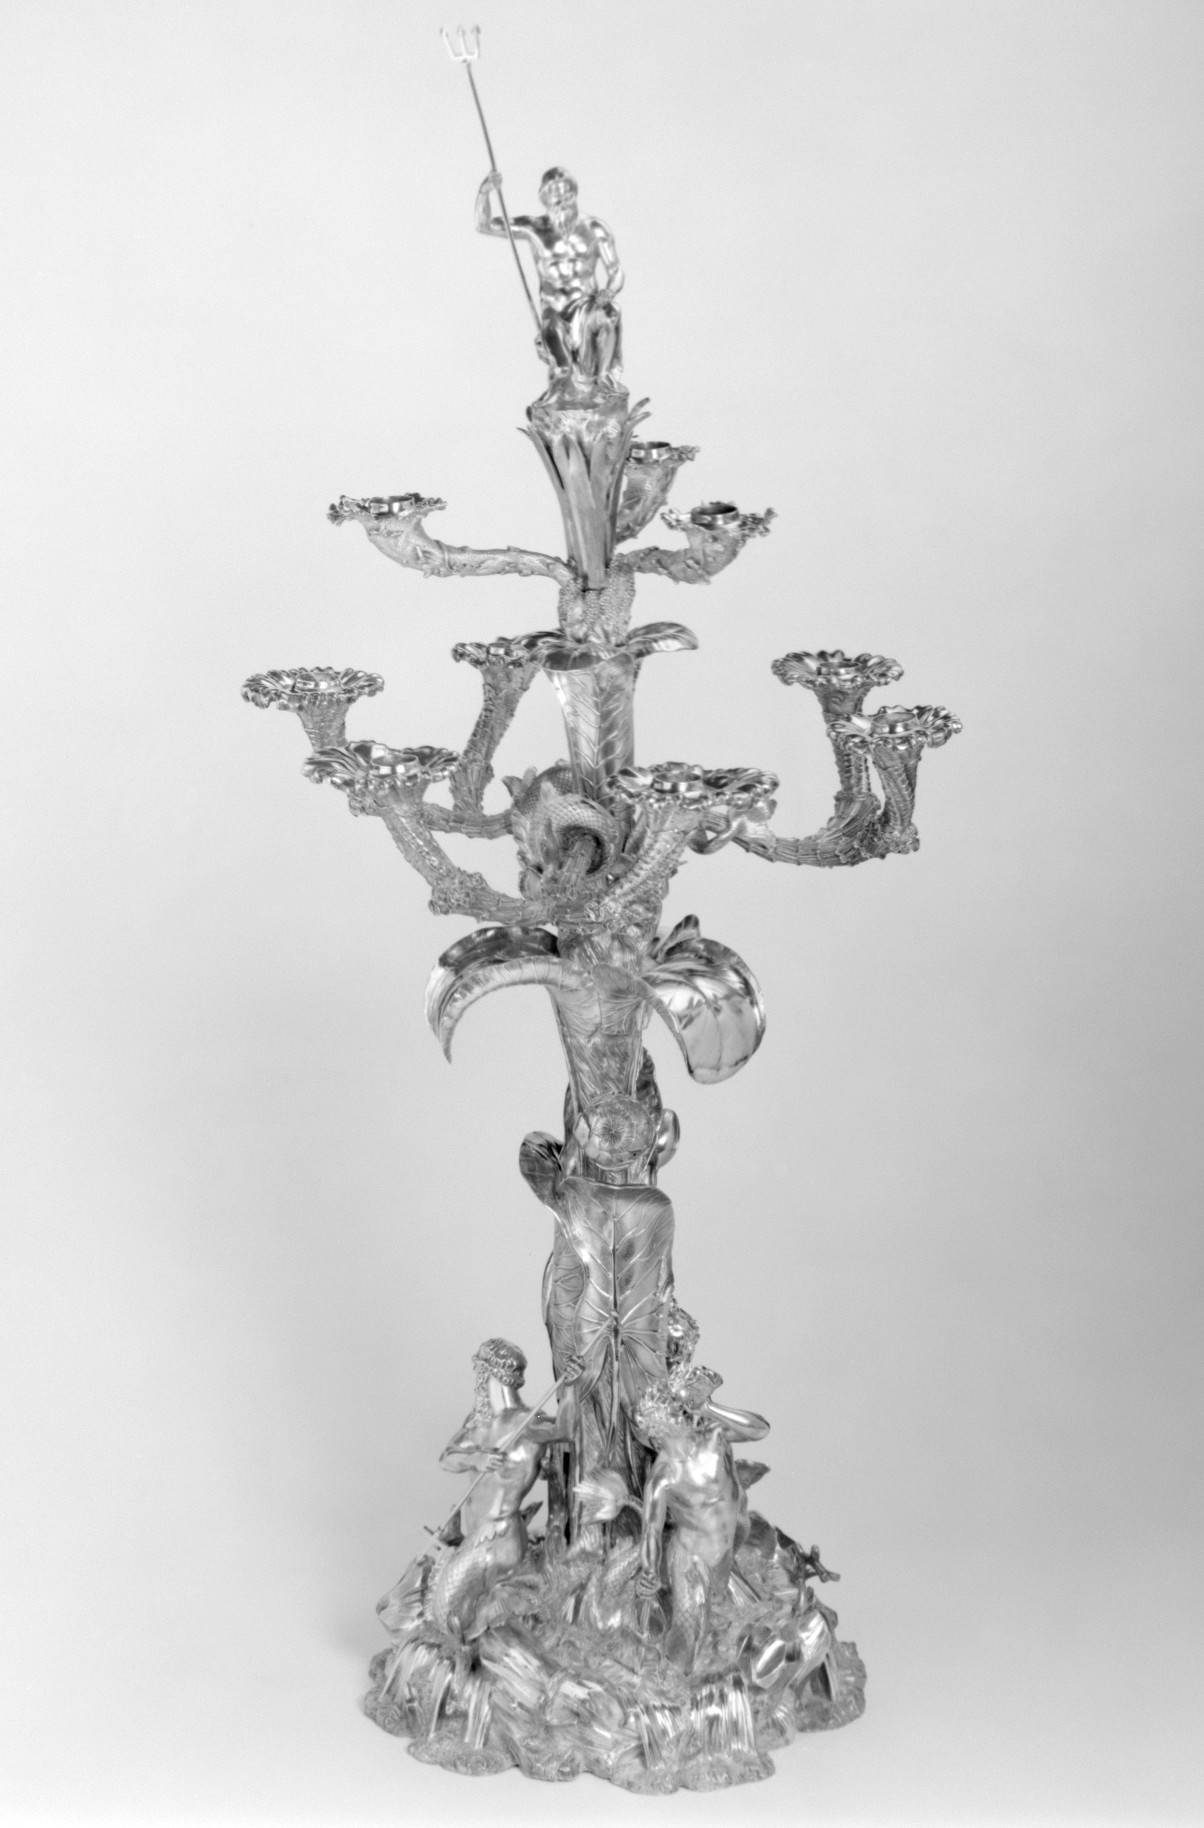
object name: candelabrum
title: Nine-light candelabrum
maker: paul storr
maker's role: maker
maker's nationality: british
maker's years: 1771-1844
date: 1838-1839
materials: silver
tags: triton,neptune